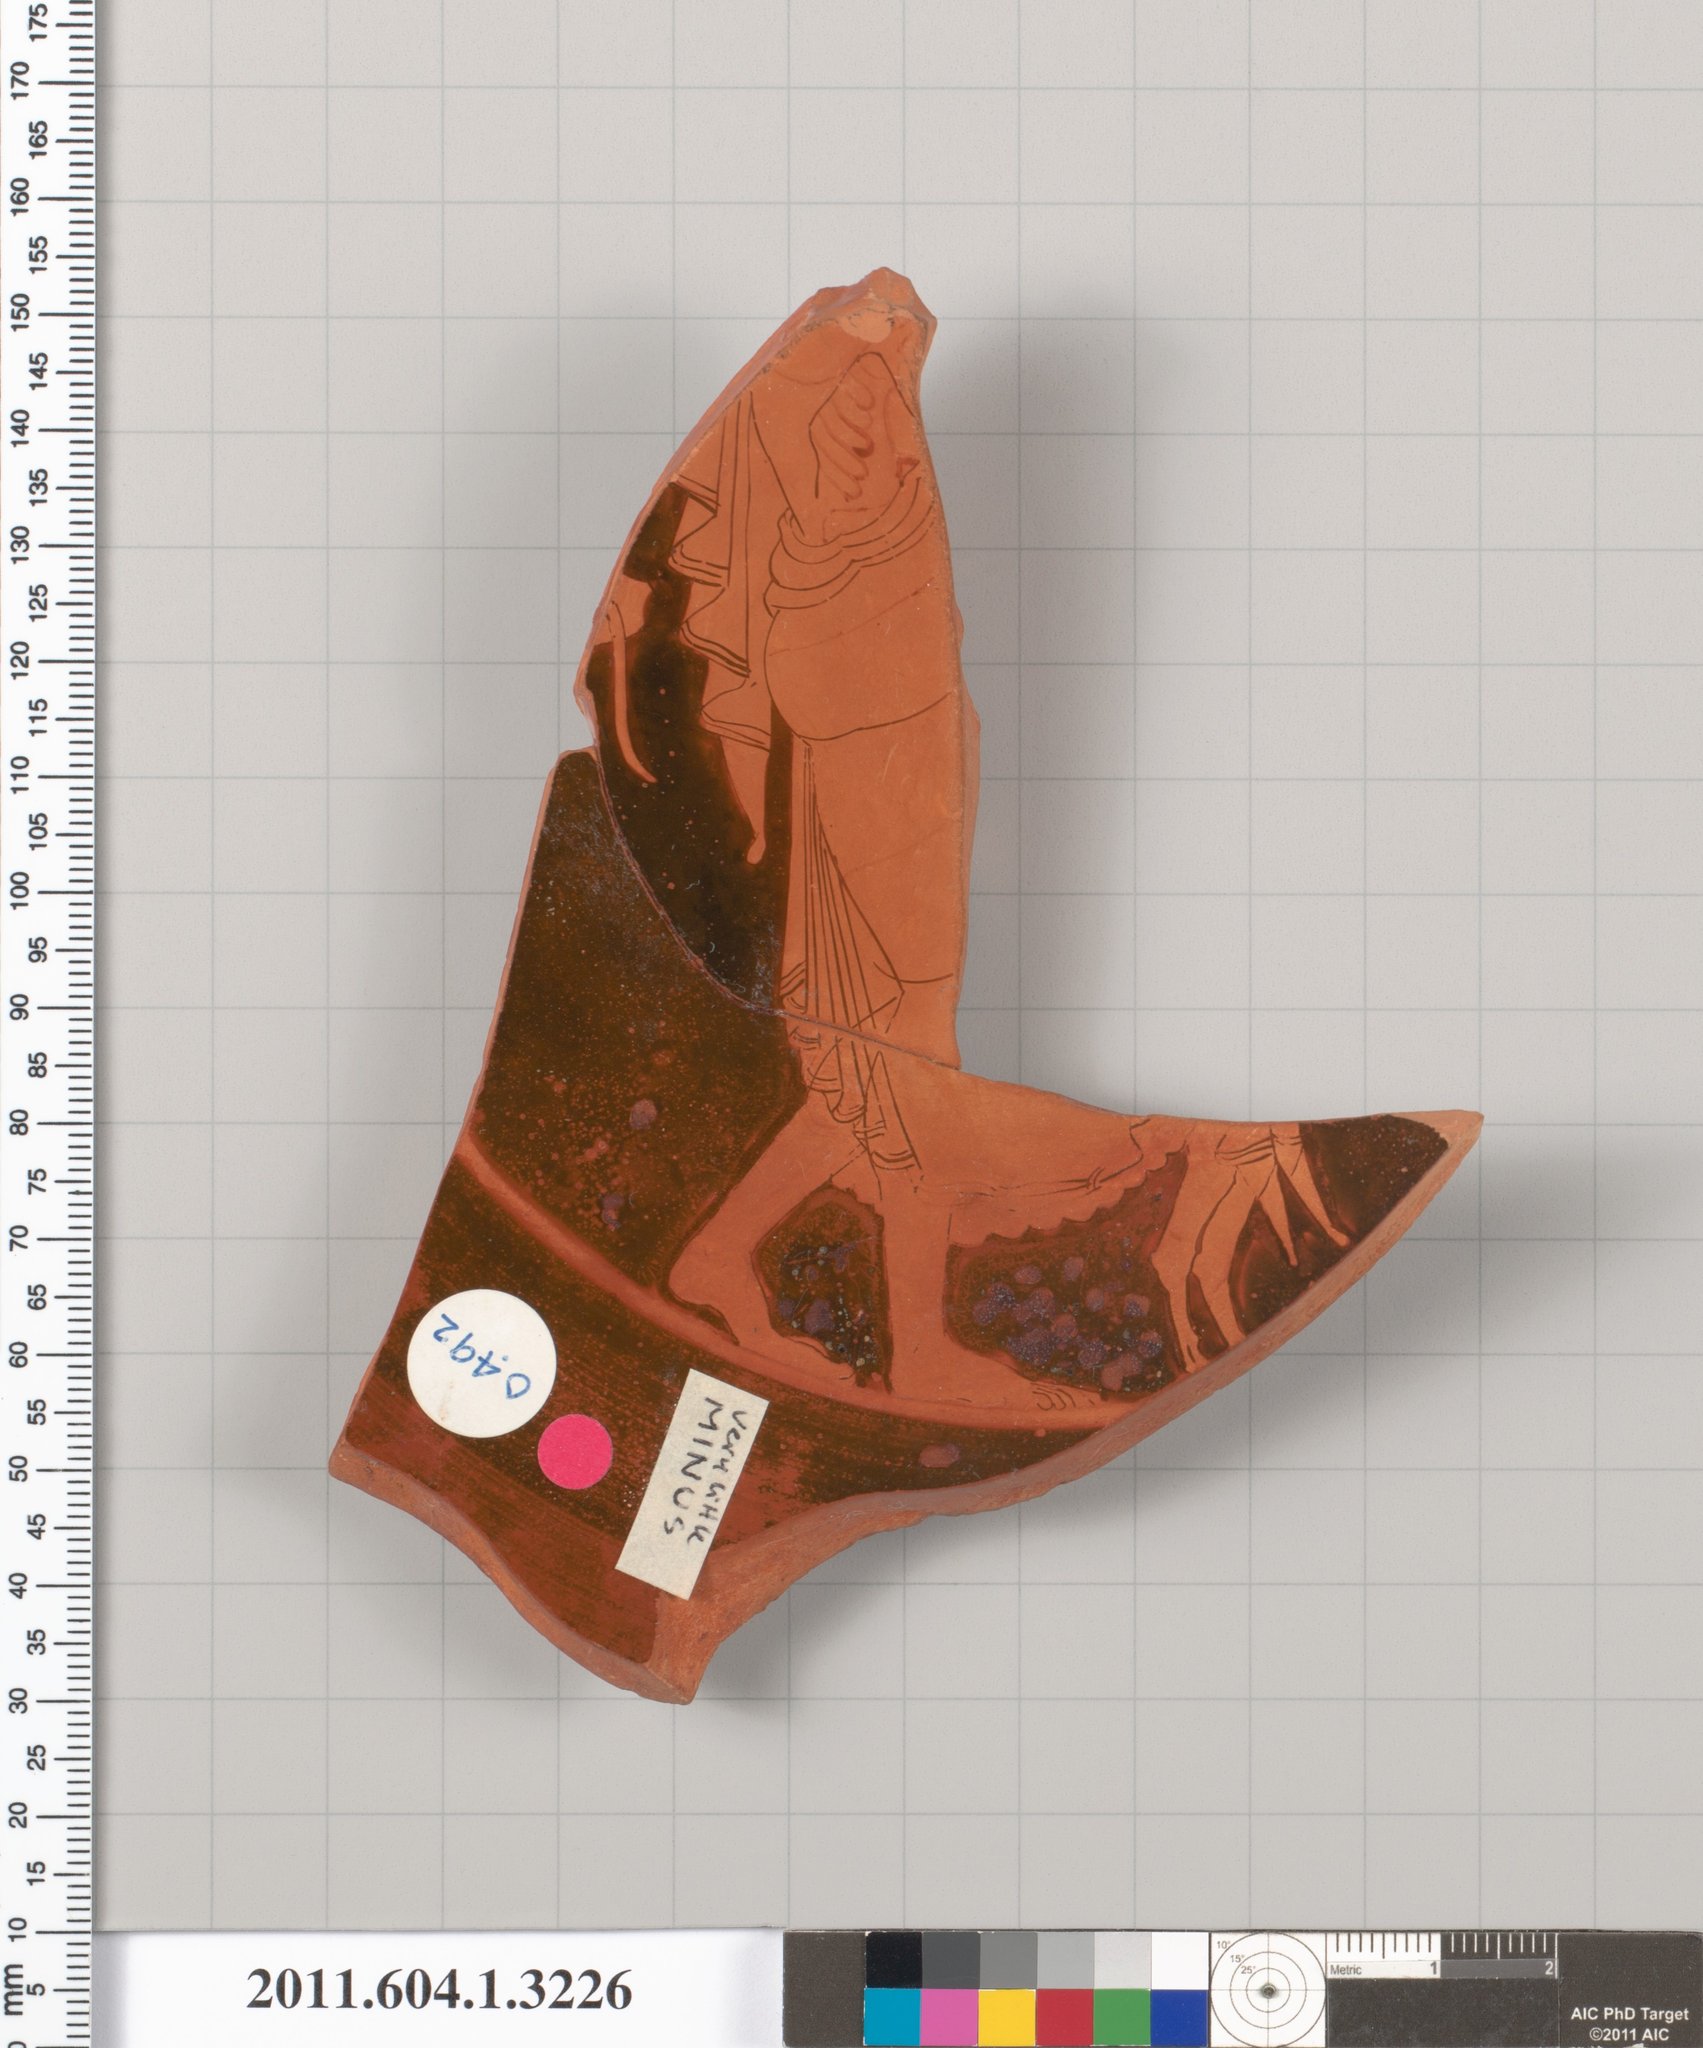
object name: kylix fragment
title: Terracotta fragment of a kylix (drinking cup)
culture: greek, attic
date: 500-490 BCE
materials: terracotta